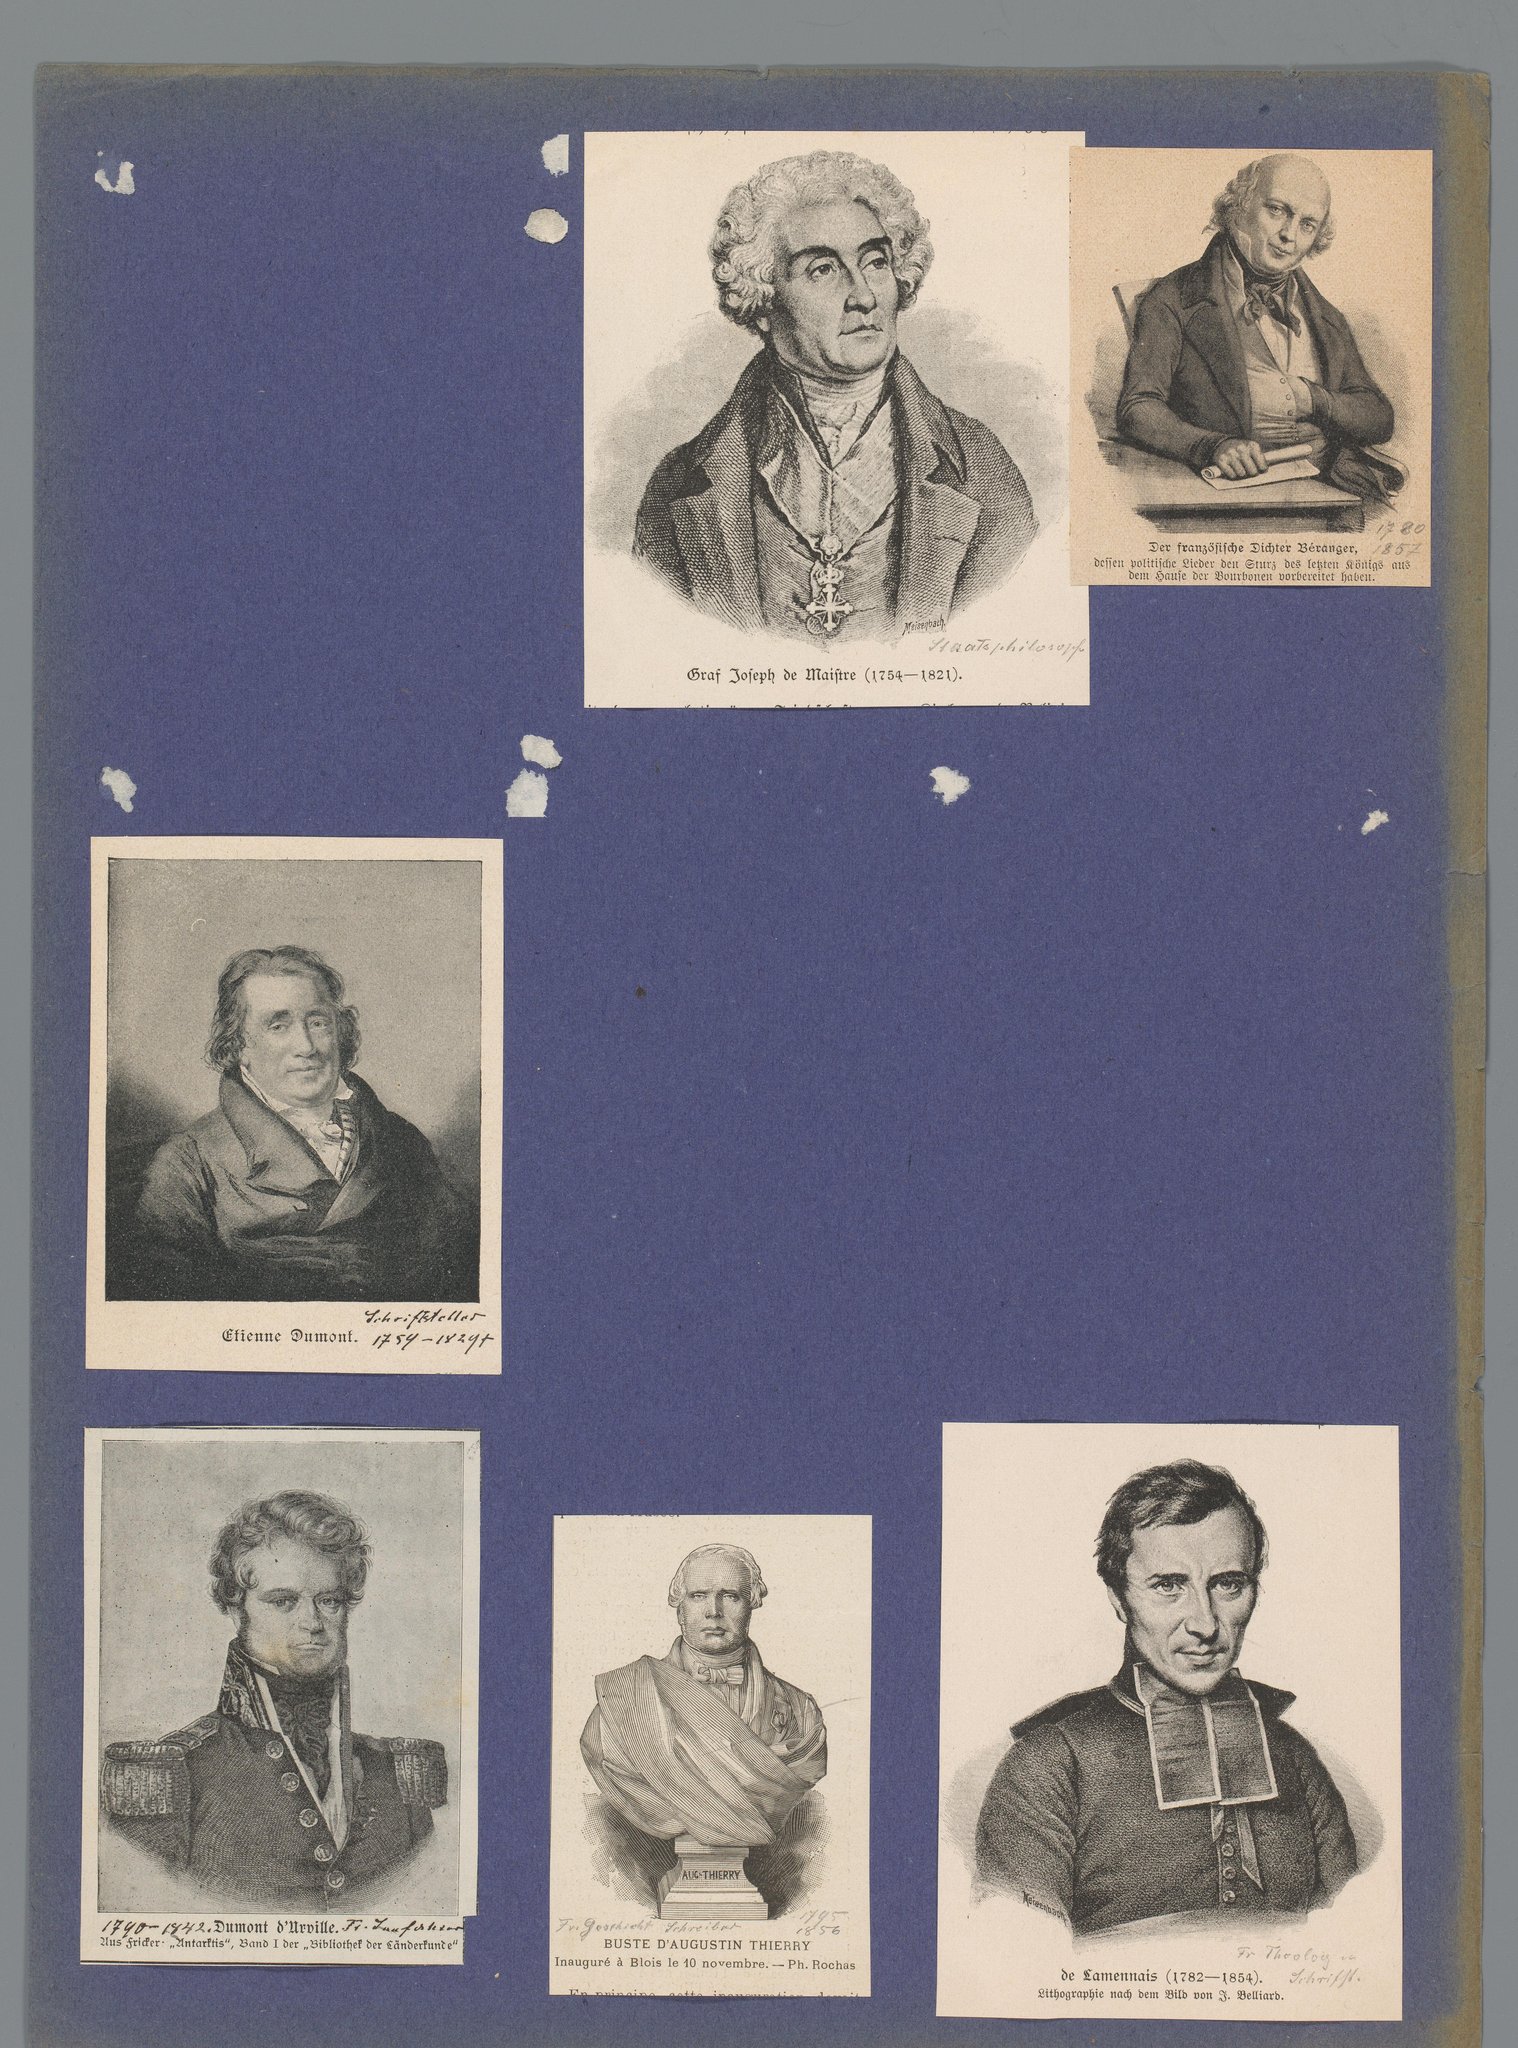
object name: sheet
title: Blad met zes portretten van historische mannen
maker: Anonymous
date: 1850-1900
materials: paper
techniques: snipping, engraving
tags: politician, paris, pierre-jean de béranger, priest, historical persons, physician, doctor (+ portrait of scholar, scientist), scholar, philosopher (+ portrait of scholar, scientist)